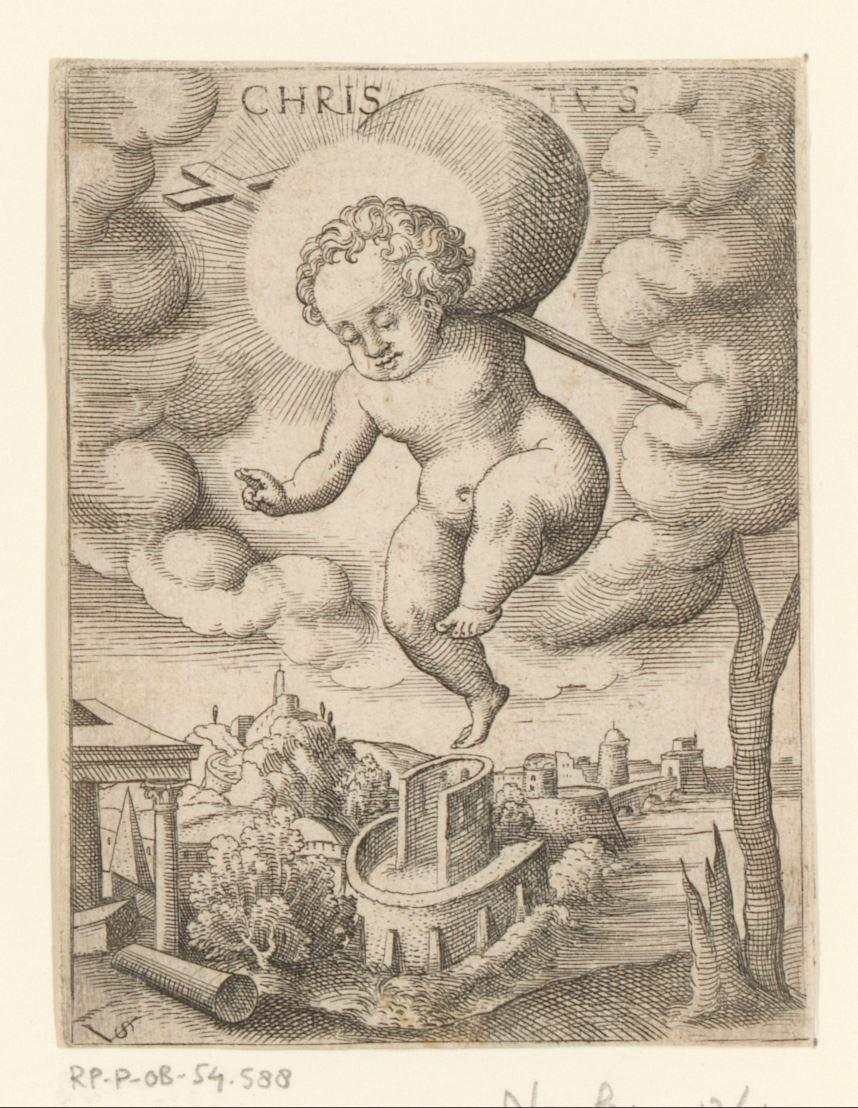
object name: print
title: Christuskind in de wolken met kruis over zijn schouder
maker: virgilius solis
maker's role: draughtsman, print maker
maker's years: 1514-1562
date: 1524-1562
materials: paper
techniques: engraving, etching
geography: nuremberg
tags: bridge in city across river, canal, etc., christ-child carrying the cross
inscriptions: collector's mark: Lugt 2228